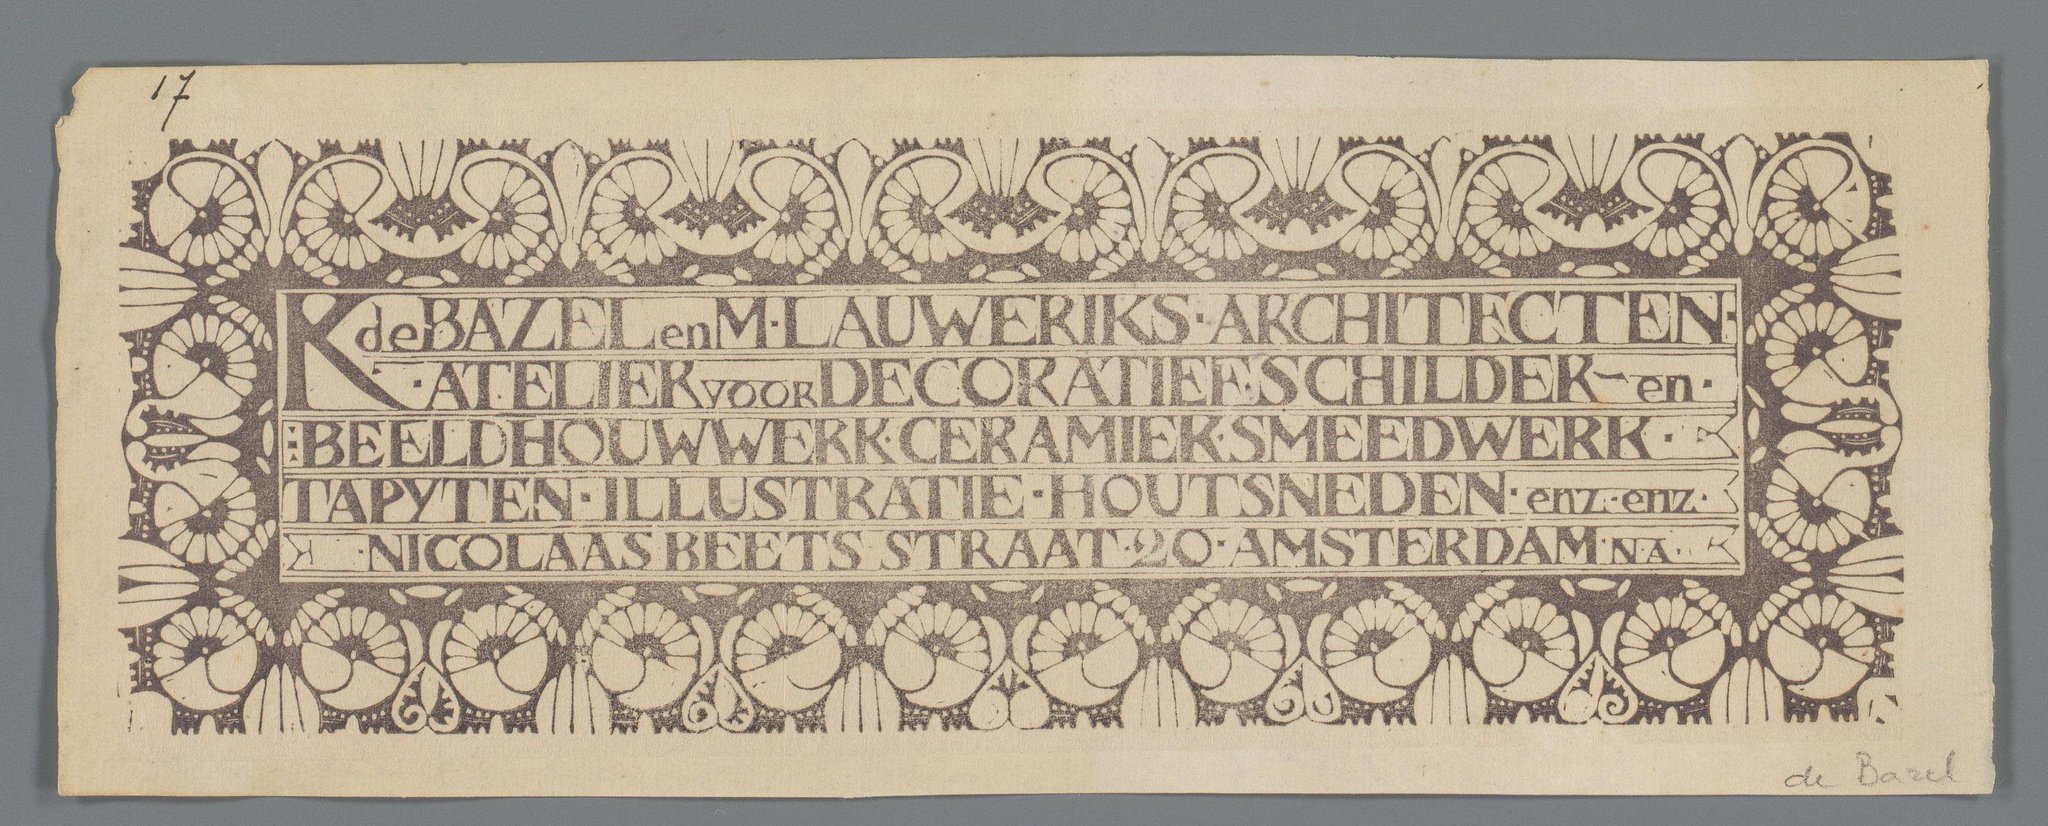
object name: letterhead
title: Briefhoofd van Mathieu Lauweriks en Karel de Bazel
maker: mathieu lauweriks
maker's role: designer, draughtsman, print maker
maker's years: 1864-1932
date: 1895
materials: paper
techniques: woodcut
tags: den helder, amsterdam, print maker, draughtsman, karel petrus cornelis de bazel, designer, mathieu lauweriks, ornaments ~ art, visiting-card, calling-card, fancy letters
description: Adres en werkzaamheden van het atelier in een decoratief kader.